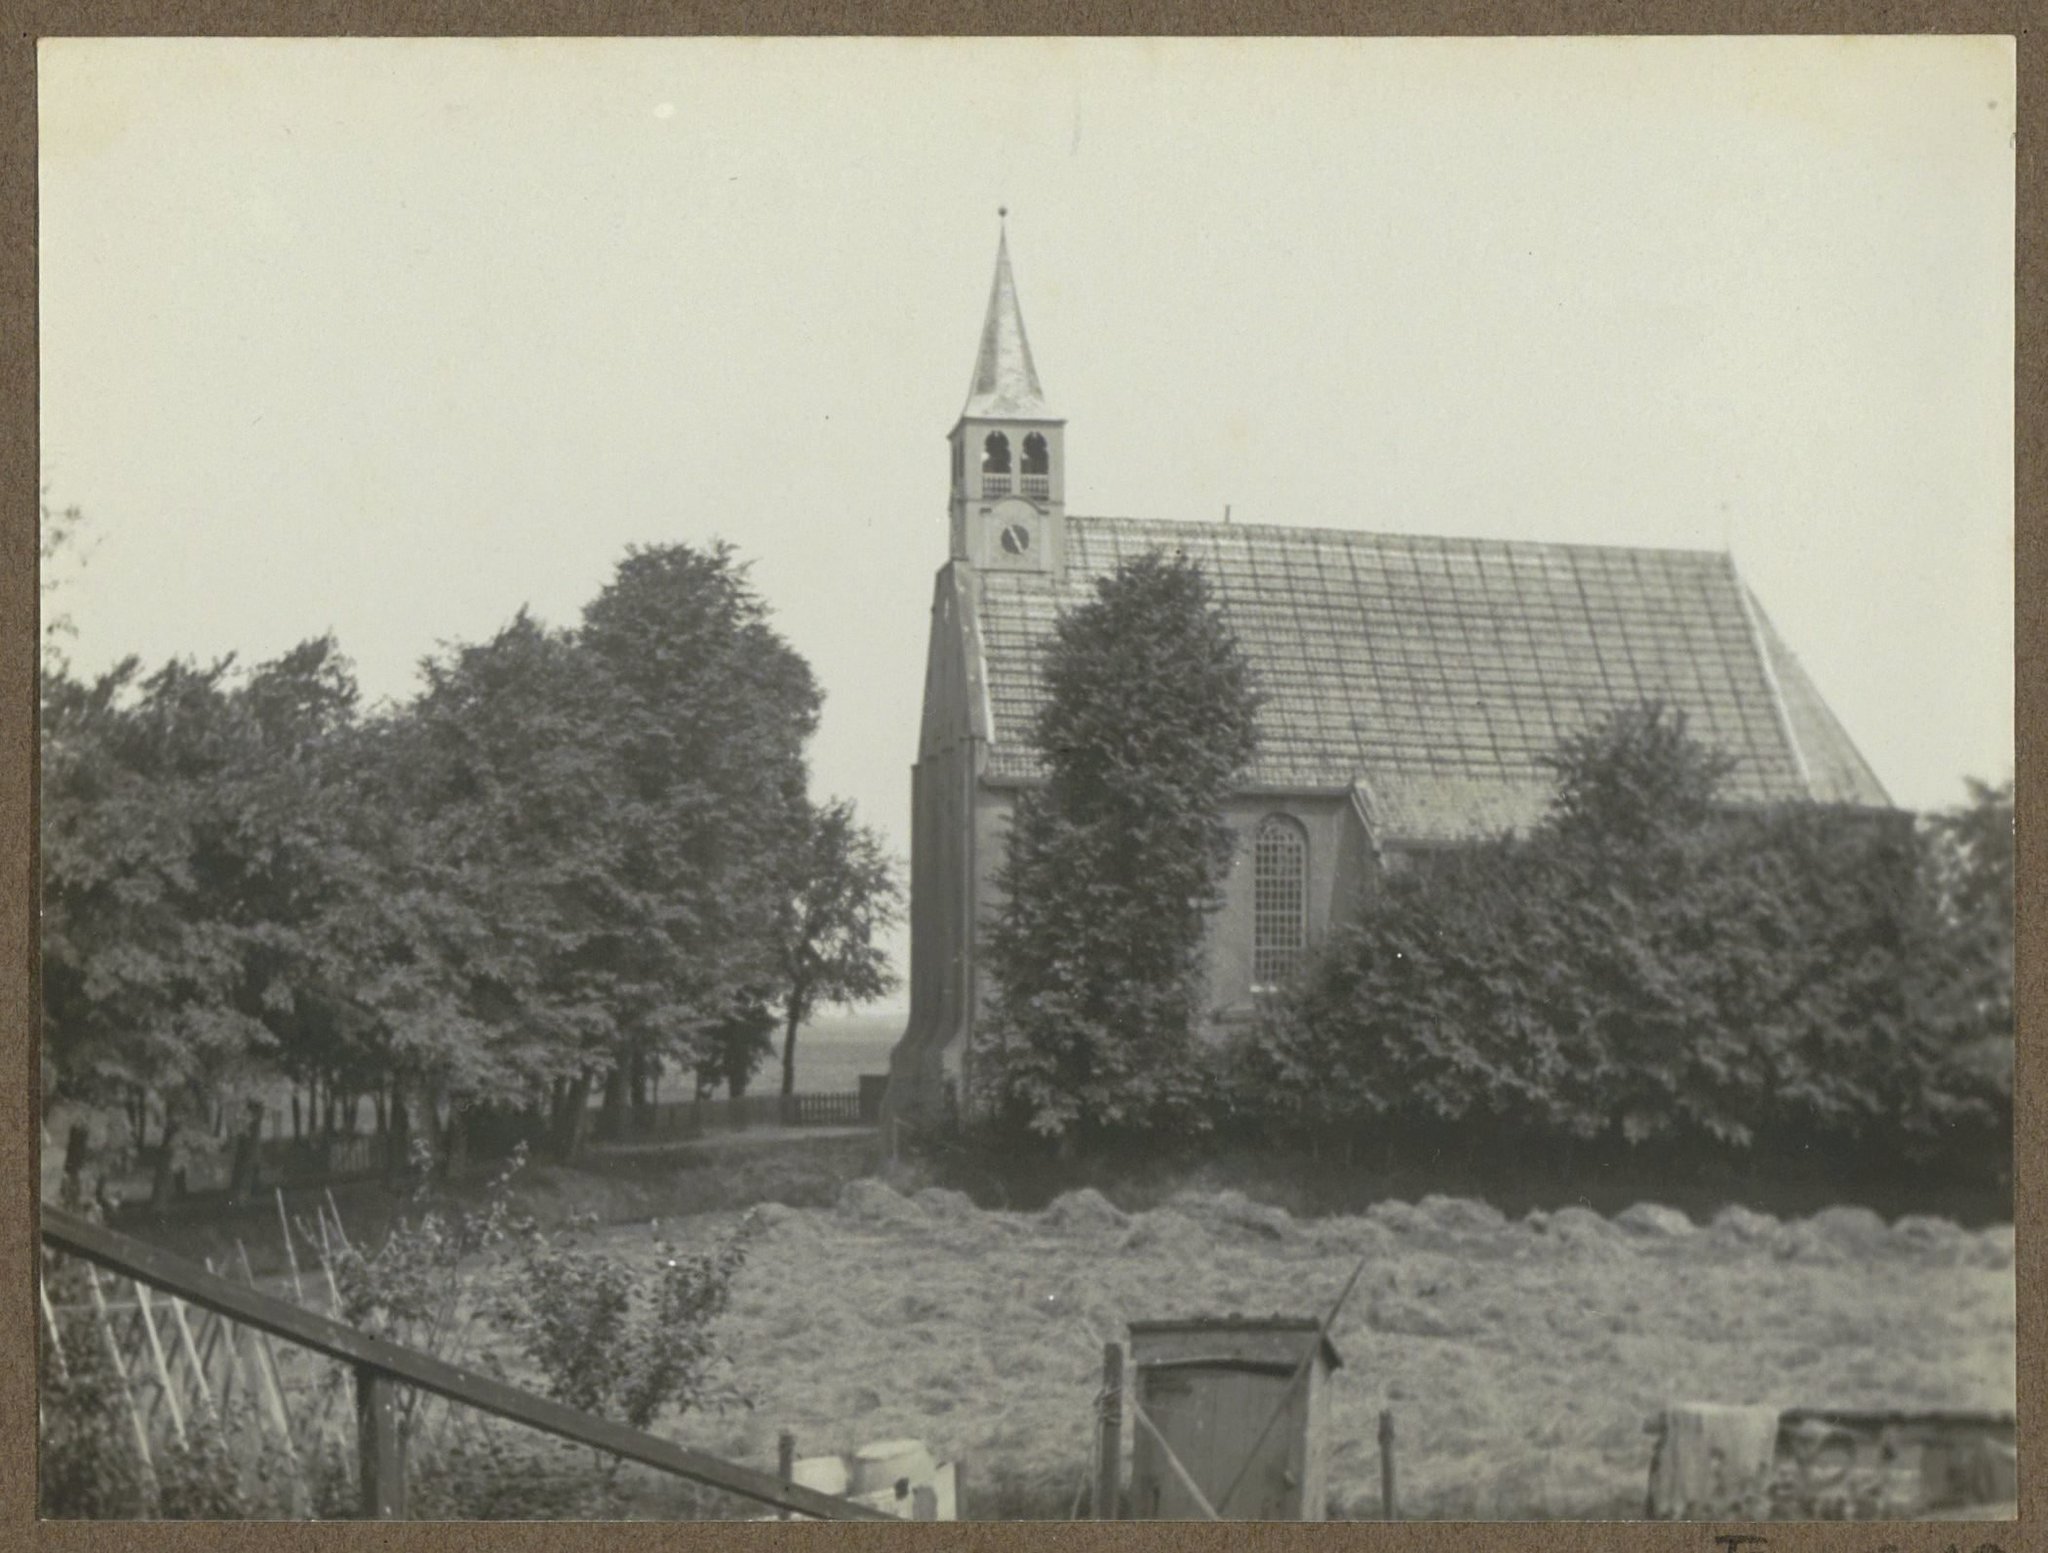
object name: photograph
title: Kerk van Buiksloot met een weiland ervoor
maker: Anonymous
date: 1910-1930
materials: paper, photographic support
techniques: gelatin silver print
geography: buiksloot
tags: church (exterior) - qq - small church, chapel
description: Onderdeel van Album met foto's van Amsterdam en omgeving.